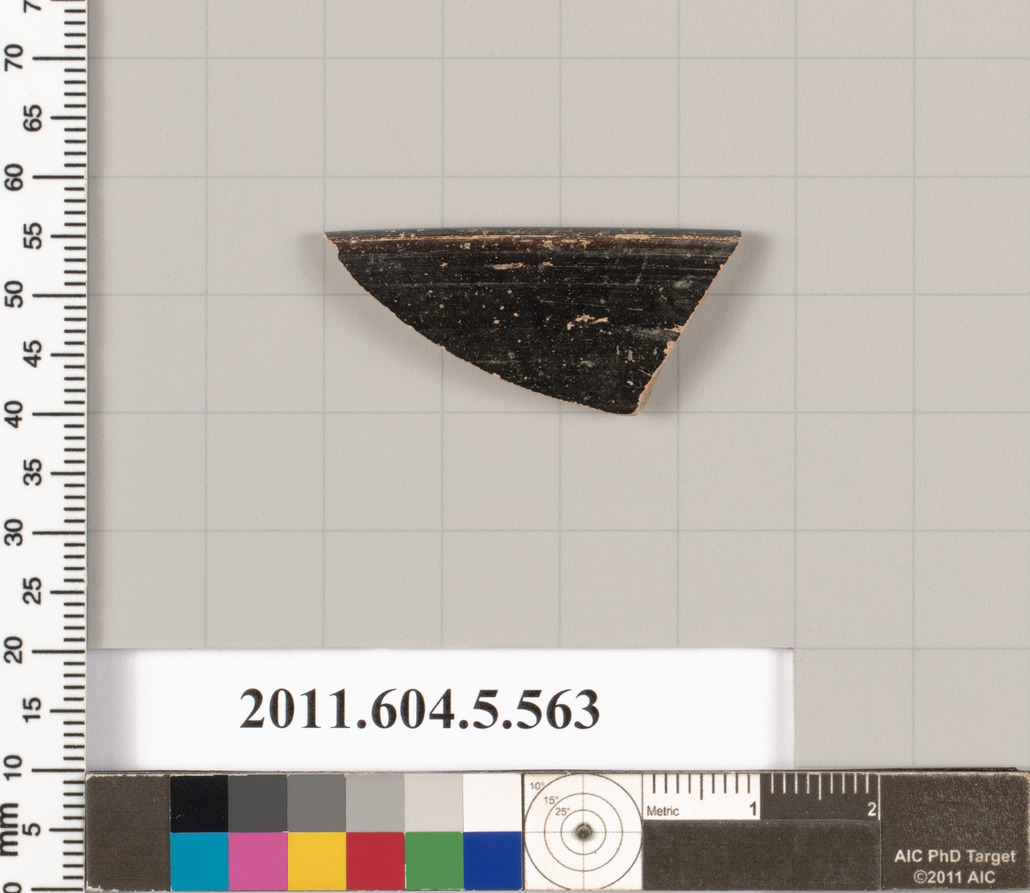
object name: kylix fragment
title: Terracotta rim fragment of a kylix (drinking cup)?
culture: greek, attic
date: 600-401 BCE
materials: terracotta